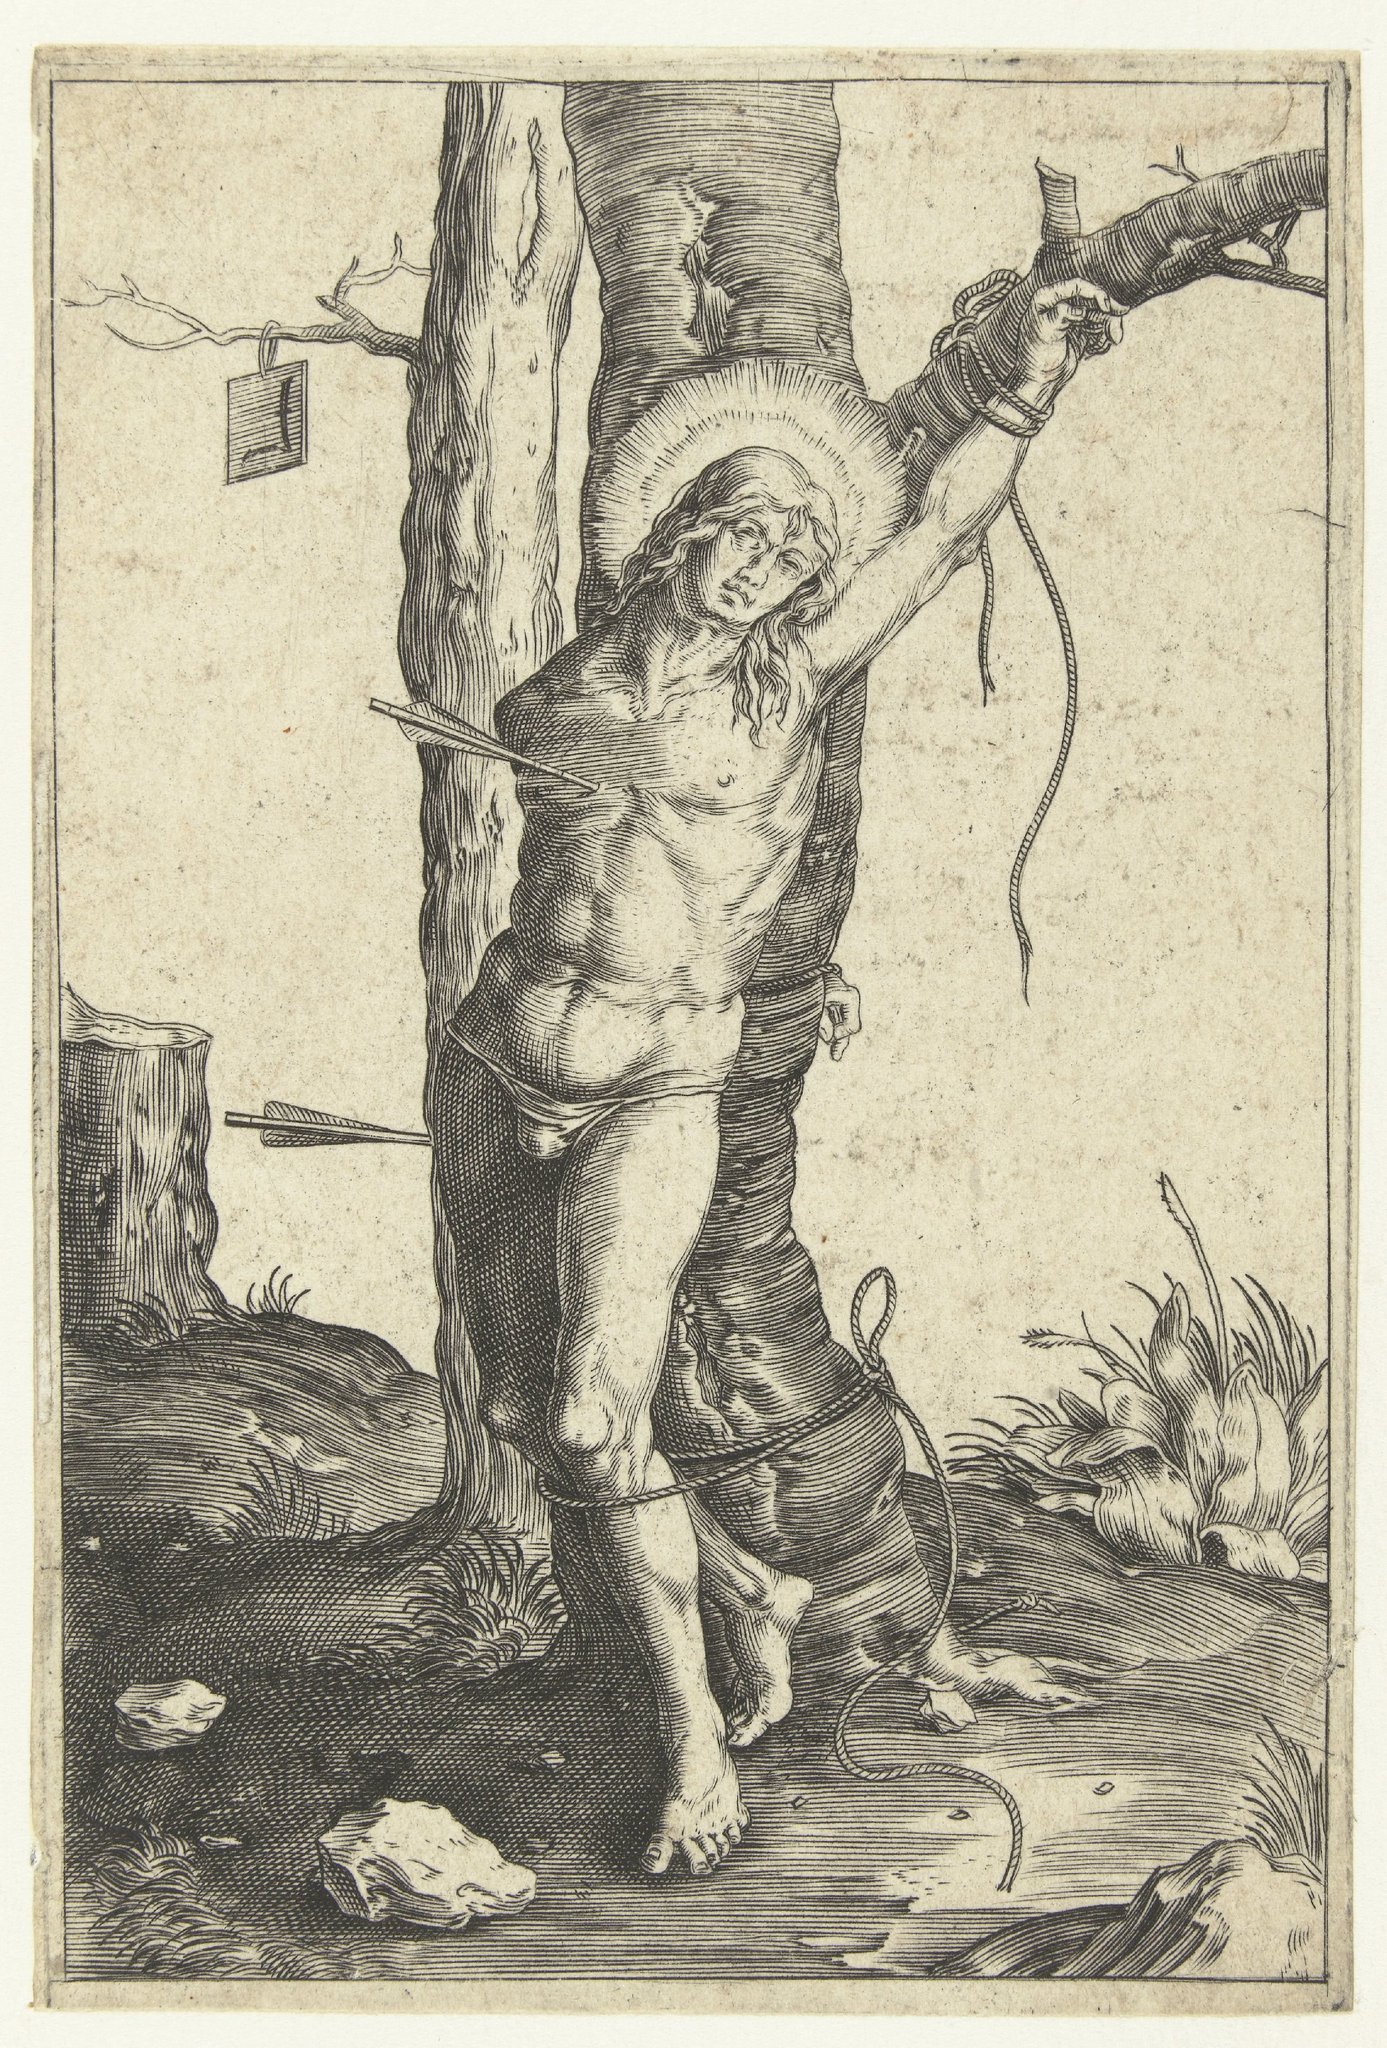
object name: print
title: De heilige Sebastiaan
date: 1581-1628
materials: paper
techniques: engraving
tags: st. sebastian, tied to a tree or a pillar, is pierced by arrows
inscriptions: collector's mark: Lugt 240